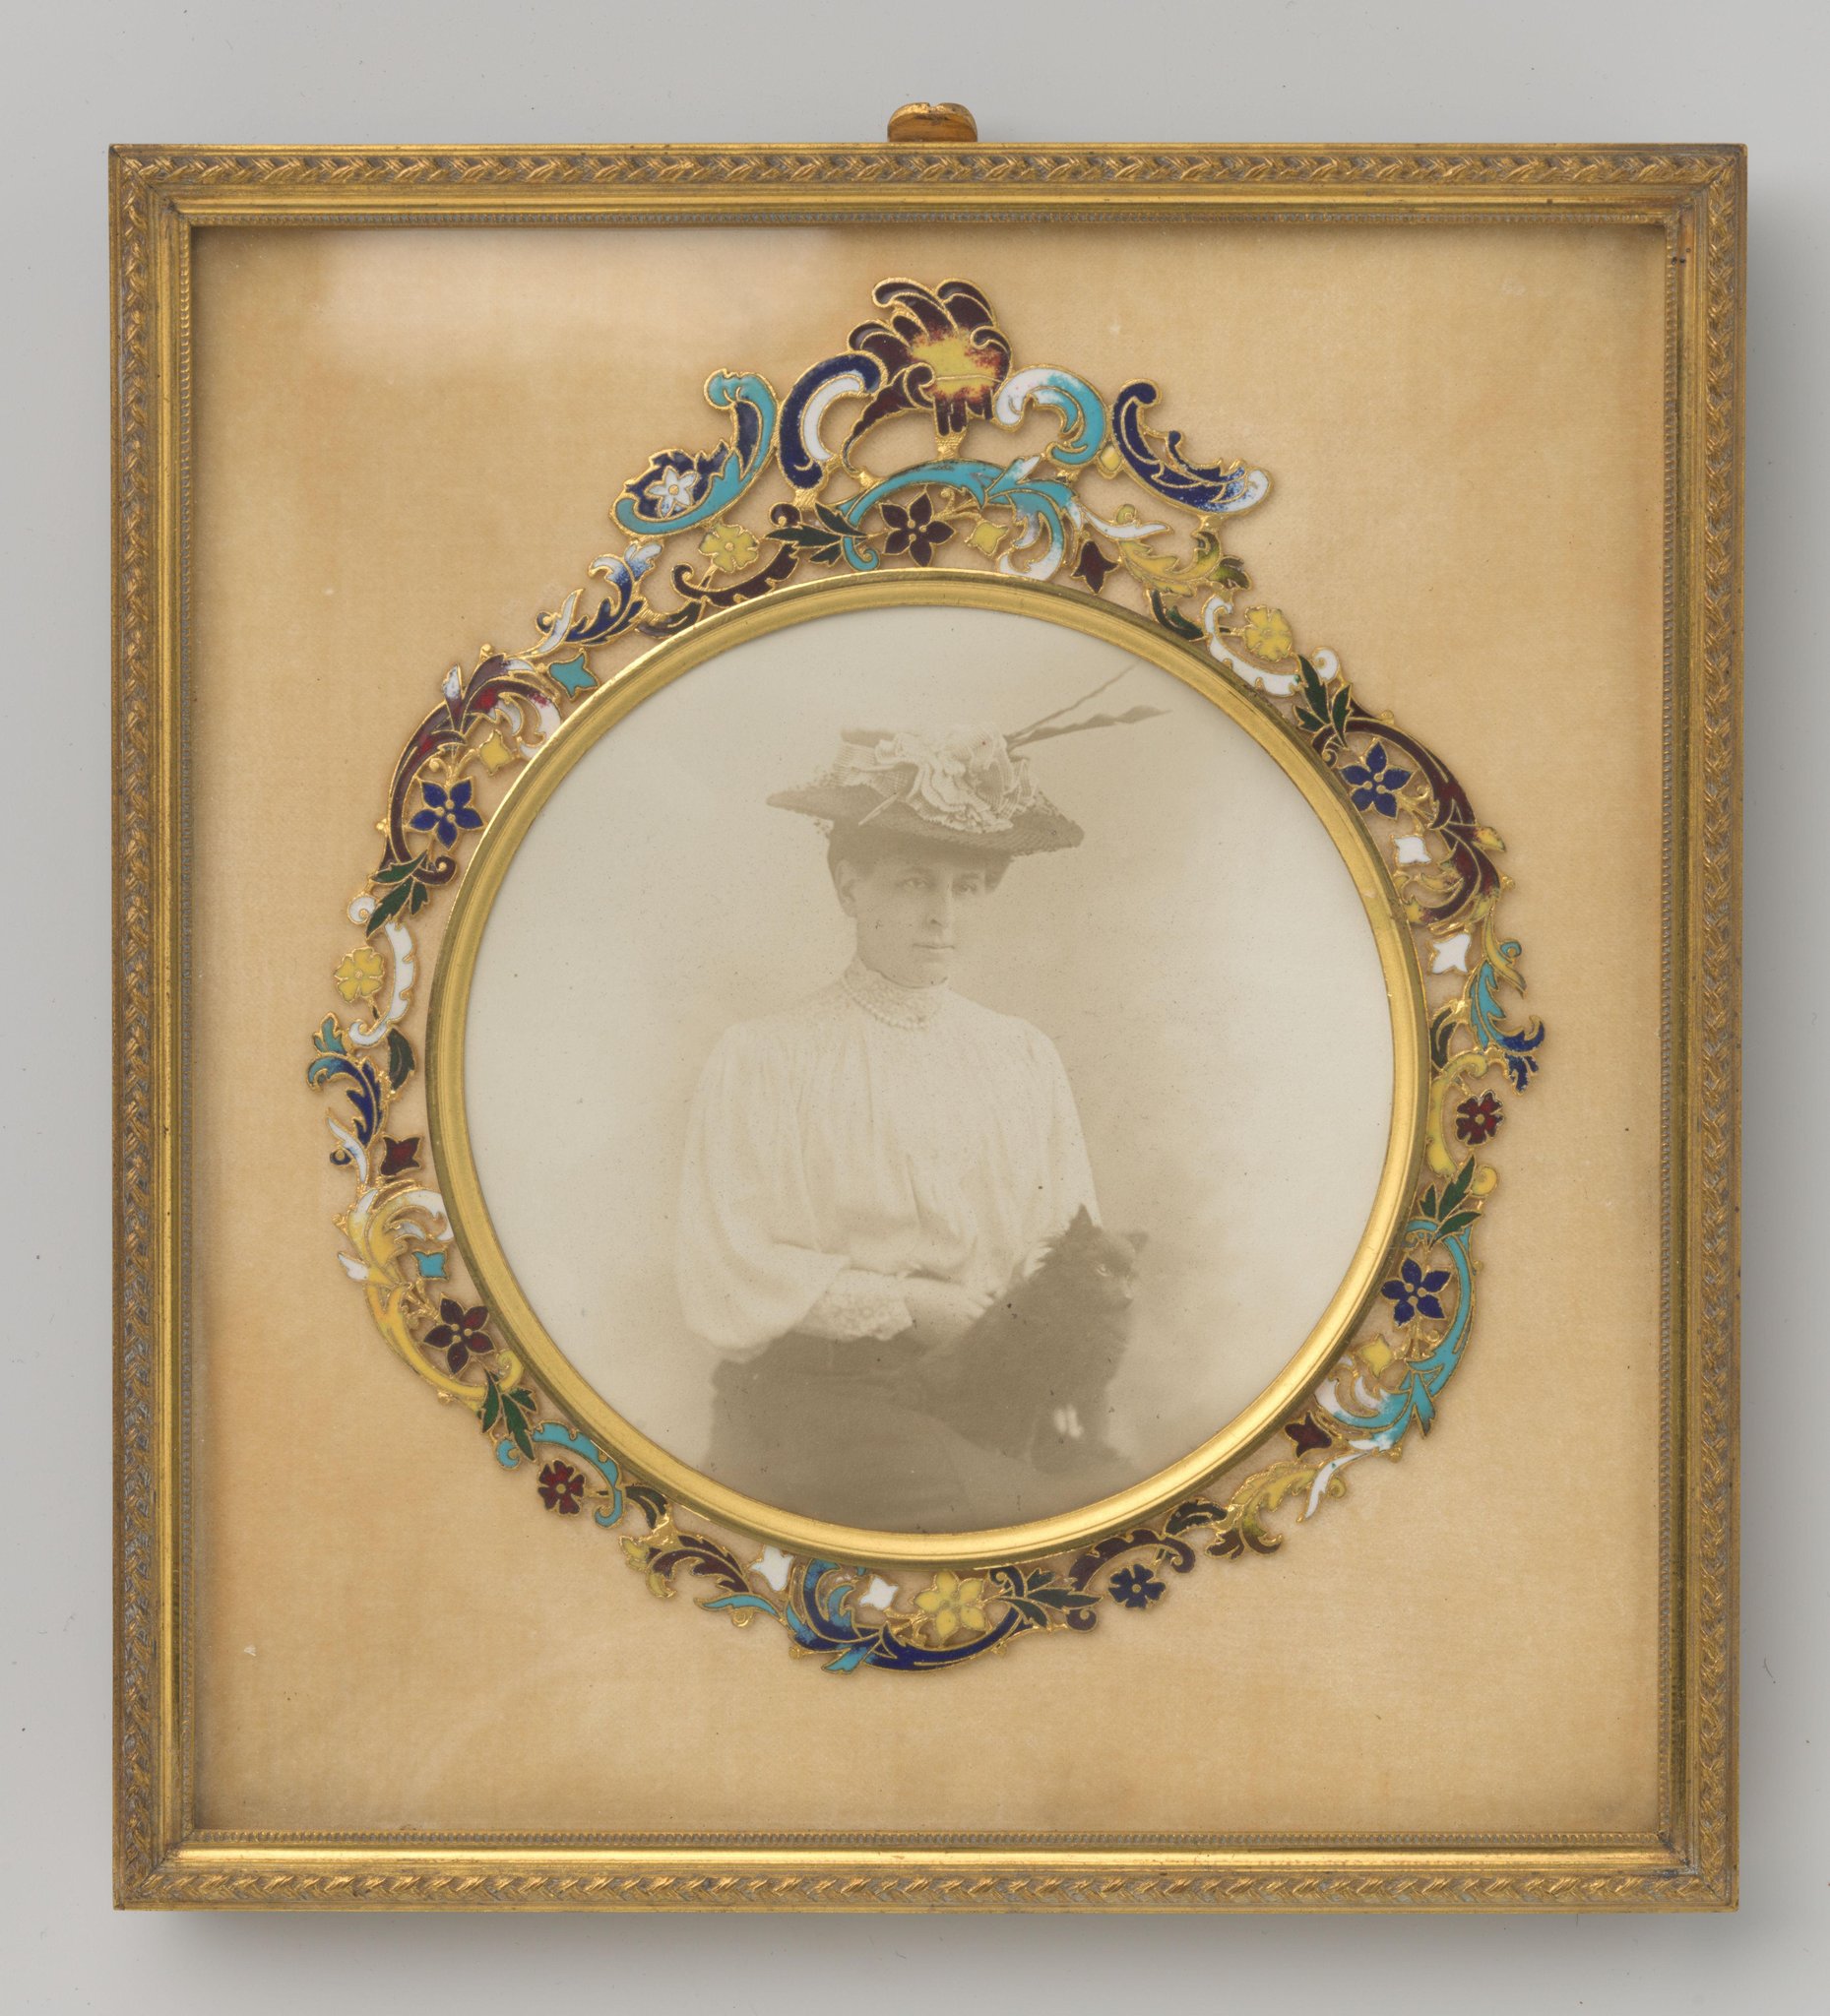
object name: photograph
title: Portret van een onbekende vrouw met een hond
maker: Anonymous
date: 1880-1900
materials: paper, cardboard, glass, metal, textile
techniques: gelatin silver print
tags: adult woman, anonymous historical person portrayed, dog